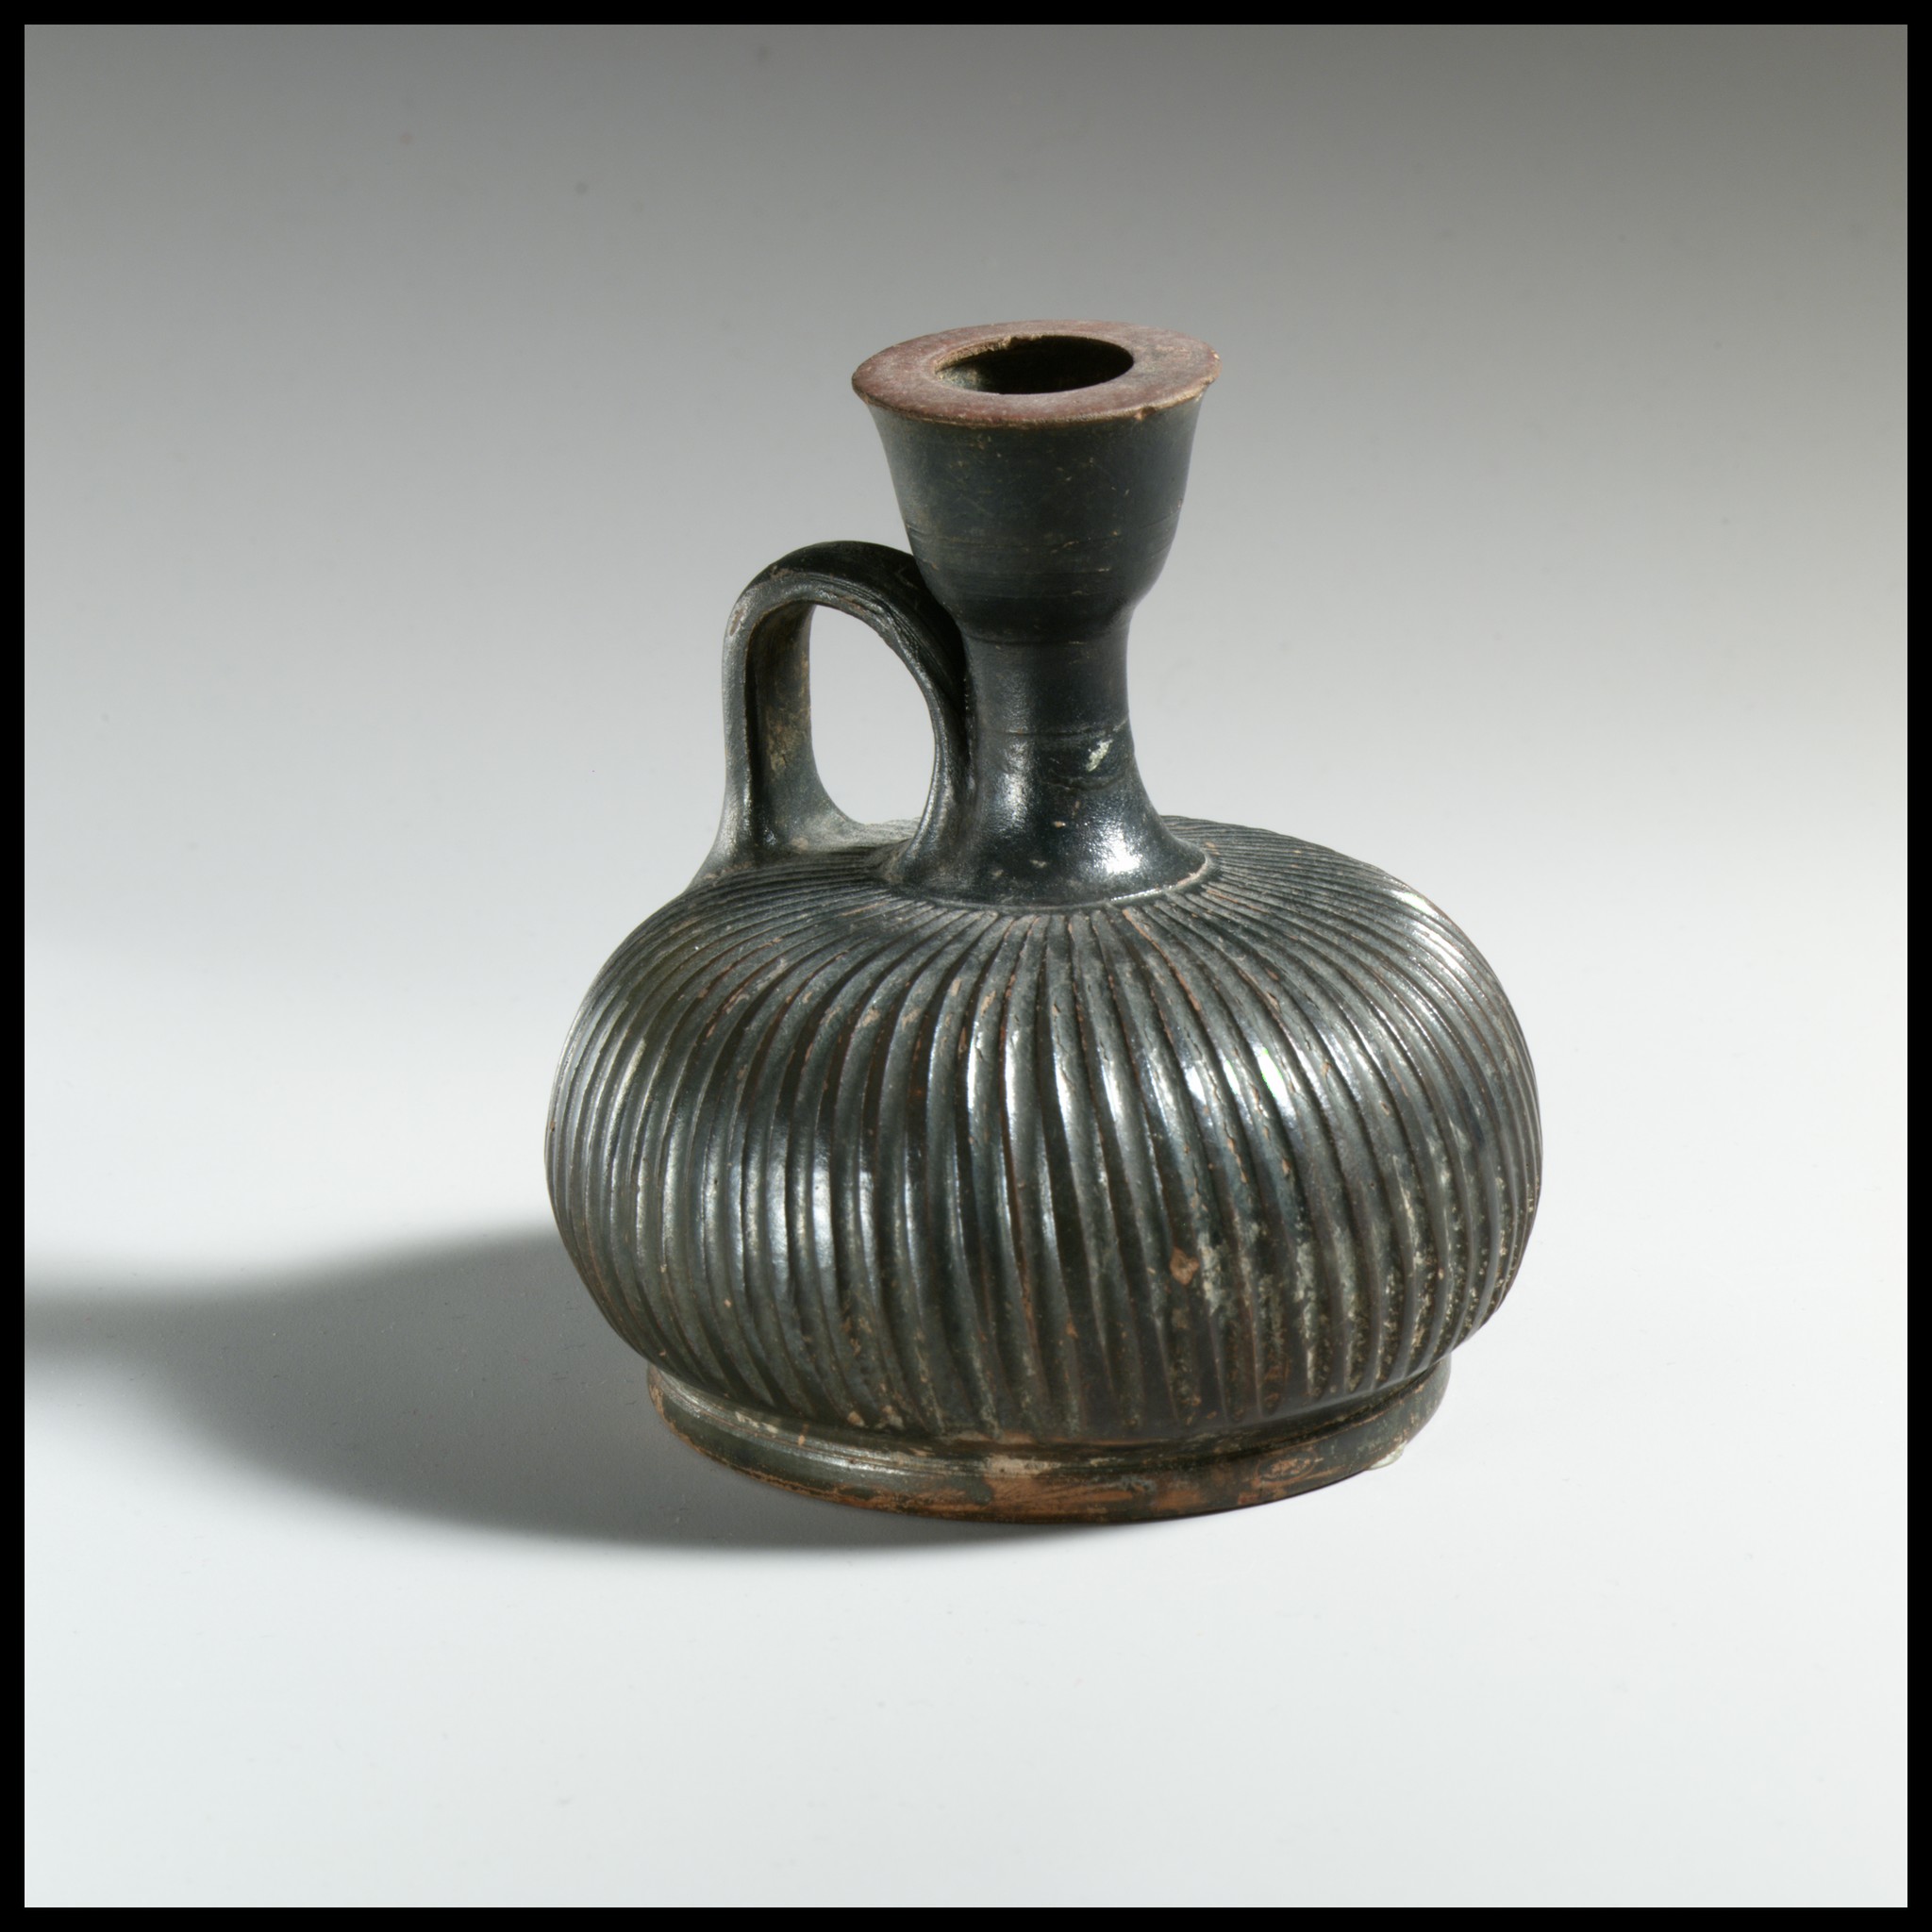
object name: squat lekythos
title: Terracotta squat lekythos (oil flask)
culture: greek or south italian or campanian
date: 400-301 BCE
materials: terracotta